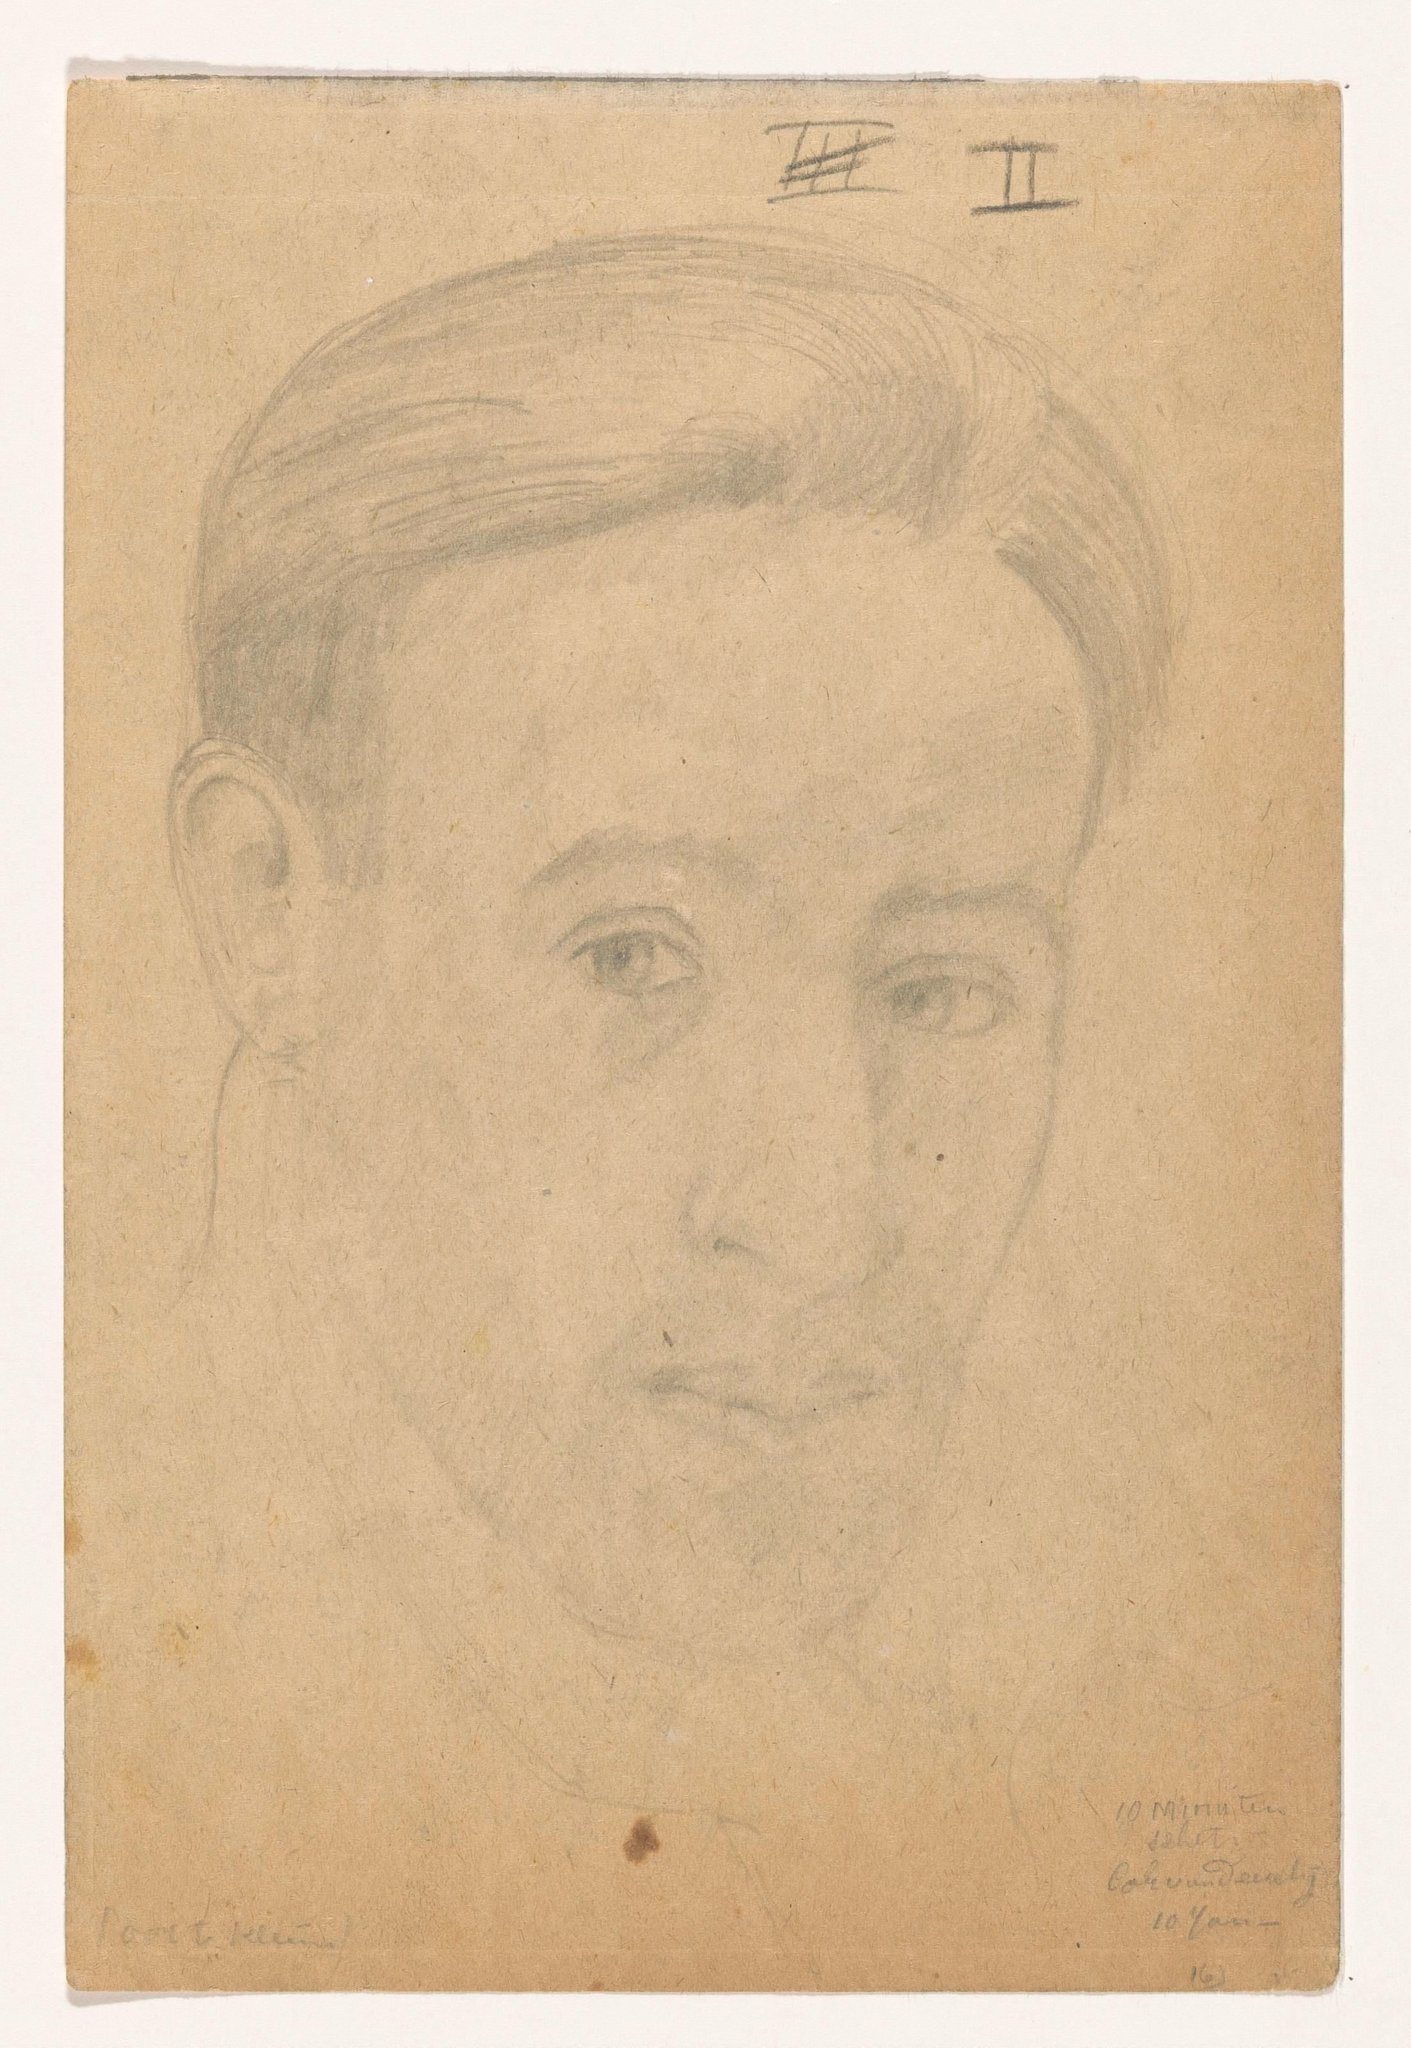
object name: drawing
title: Zelfportret en face: B-1-1, 10 januari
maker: cor van teeseling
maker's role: draughtsman, sculptor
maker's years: 1915-1942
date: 1942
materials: chalk, paper, pencil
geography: weteringschans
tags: amsterdam, draughtsman, cor van teeseling, portrait, self-portrait of draughtsman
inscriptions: date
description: Zelfportret Cor van Teeseling en face: B-1-1, 10 januari. Op keerzijde eveneens zelfportret in de gevangenis aan Weteringschans, cel: B-1-1.